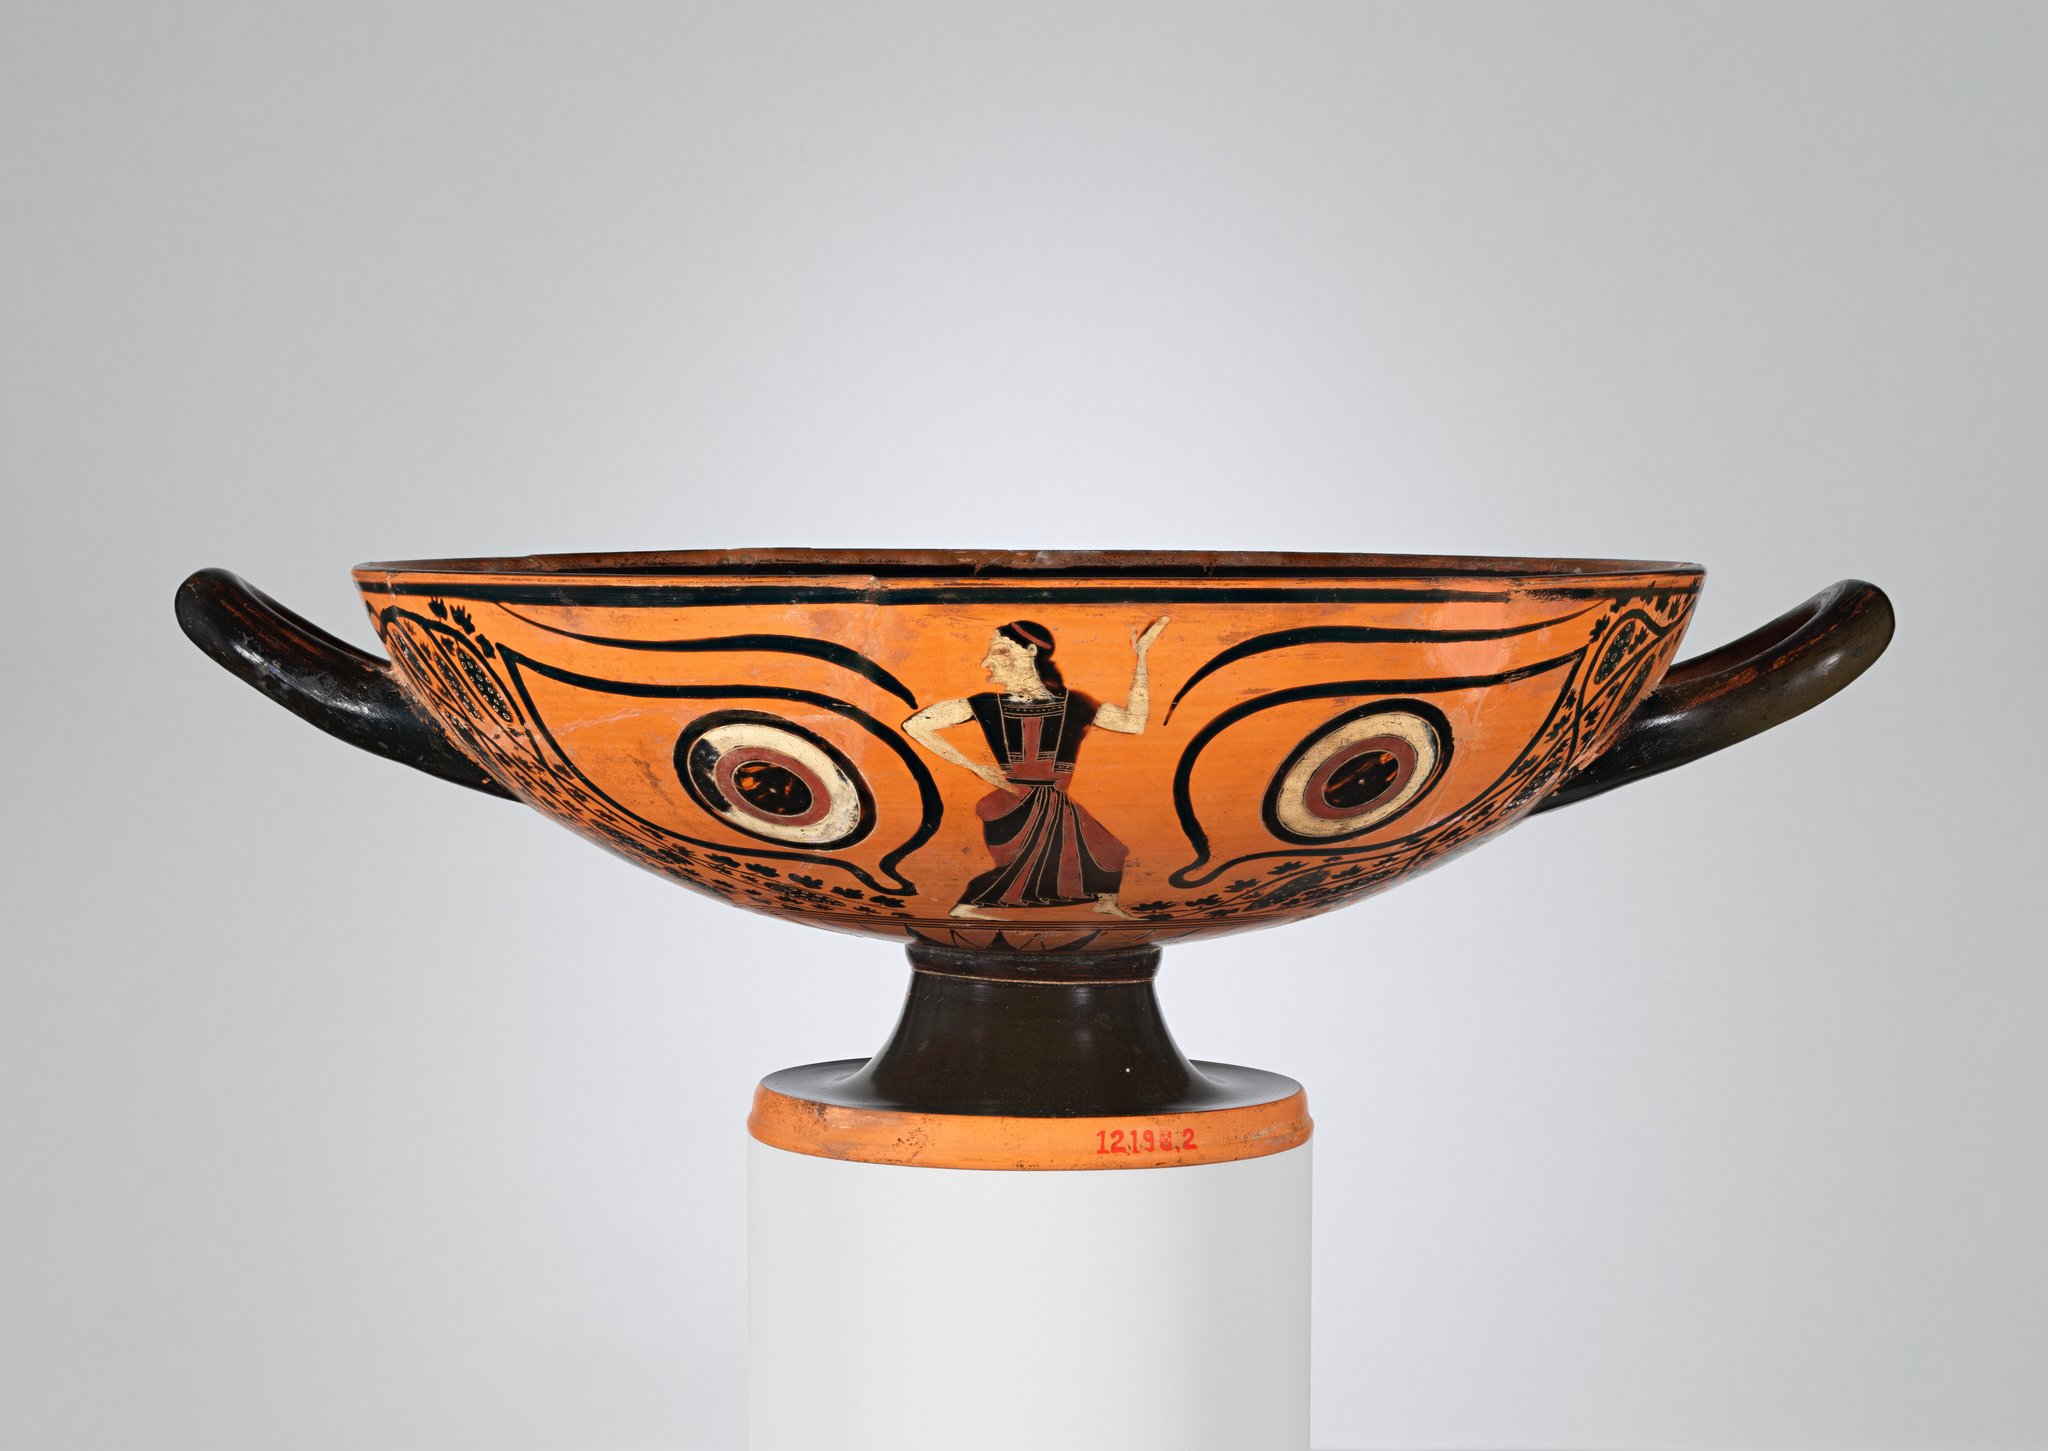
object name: kylix, eye cup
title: Terracotta kylix: eye-cup (drinking cup)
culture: greek, attic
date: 530 BCE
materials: terracotta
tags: eyes